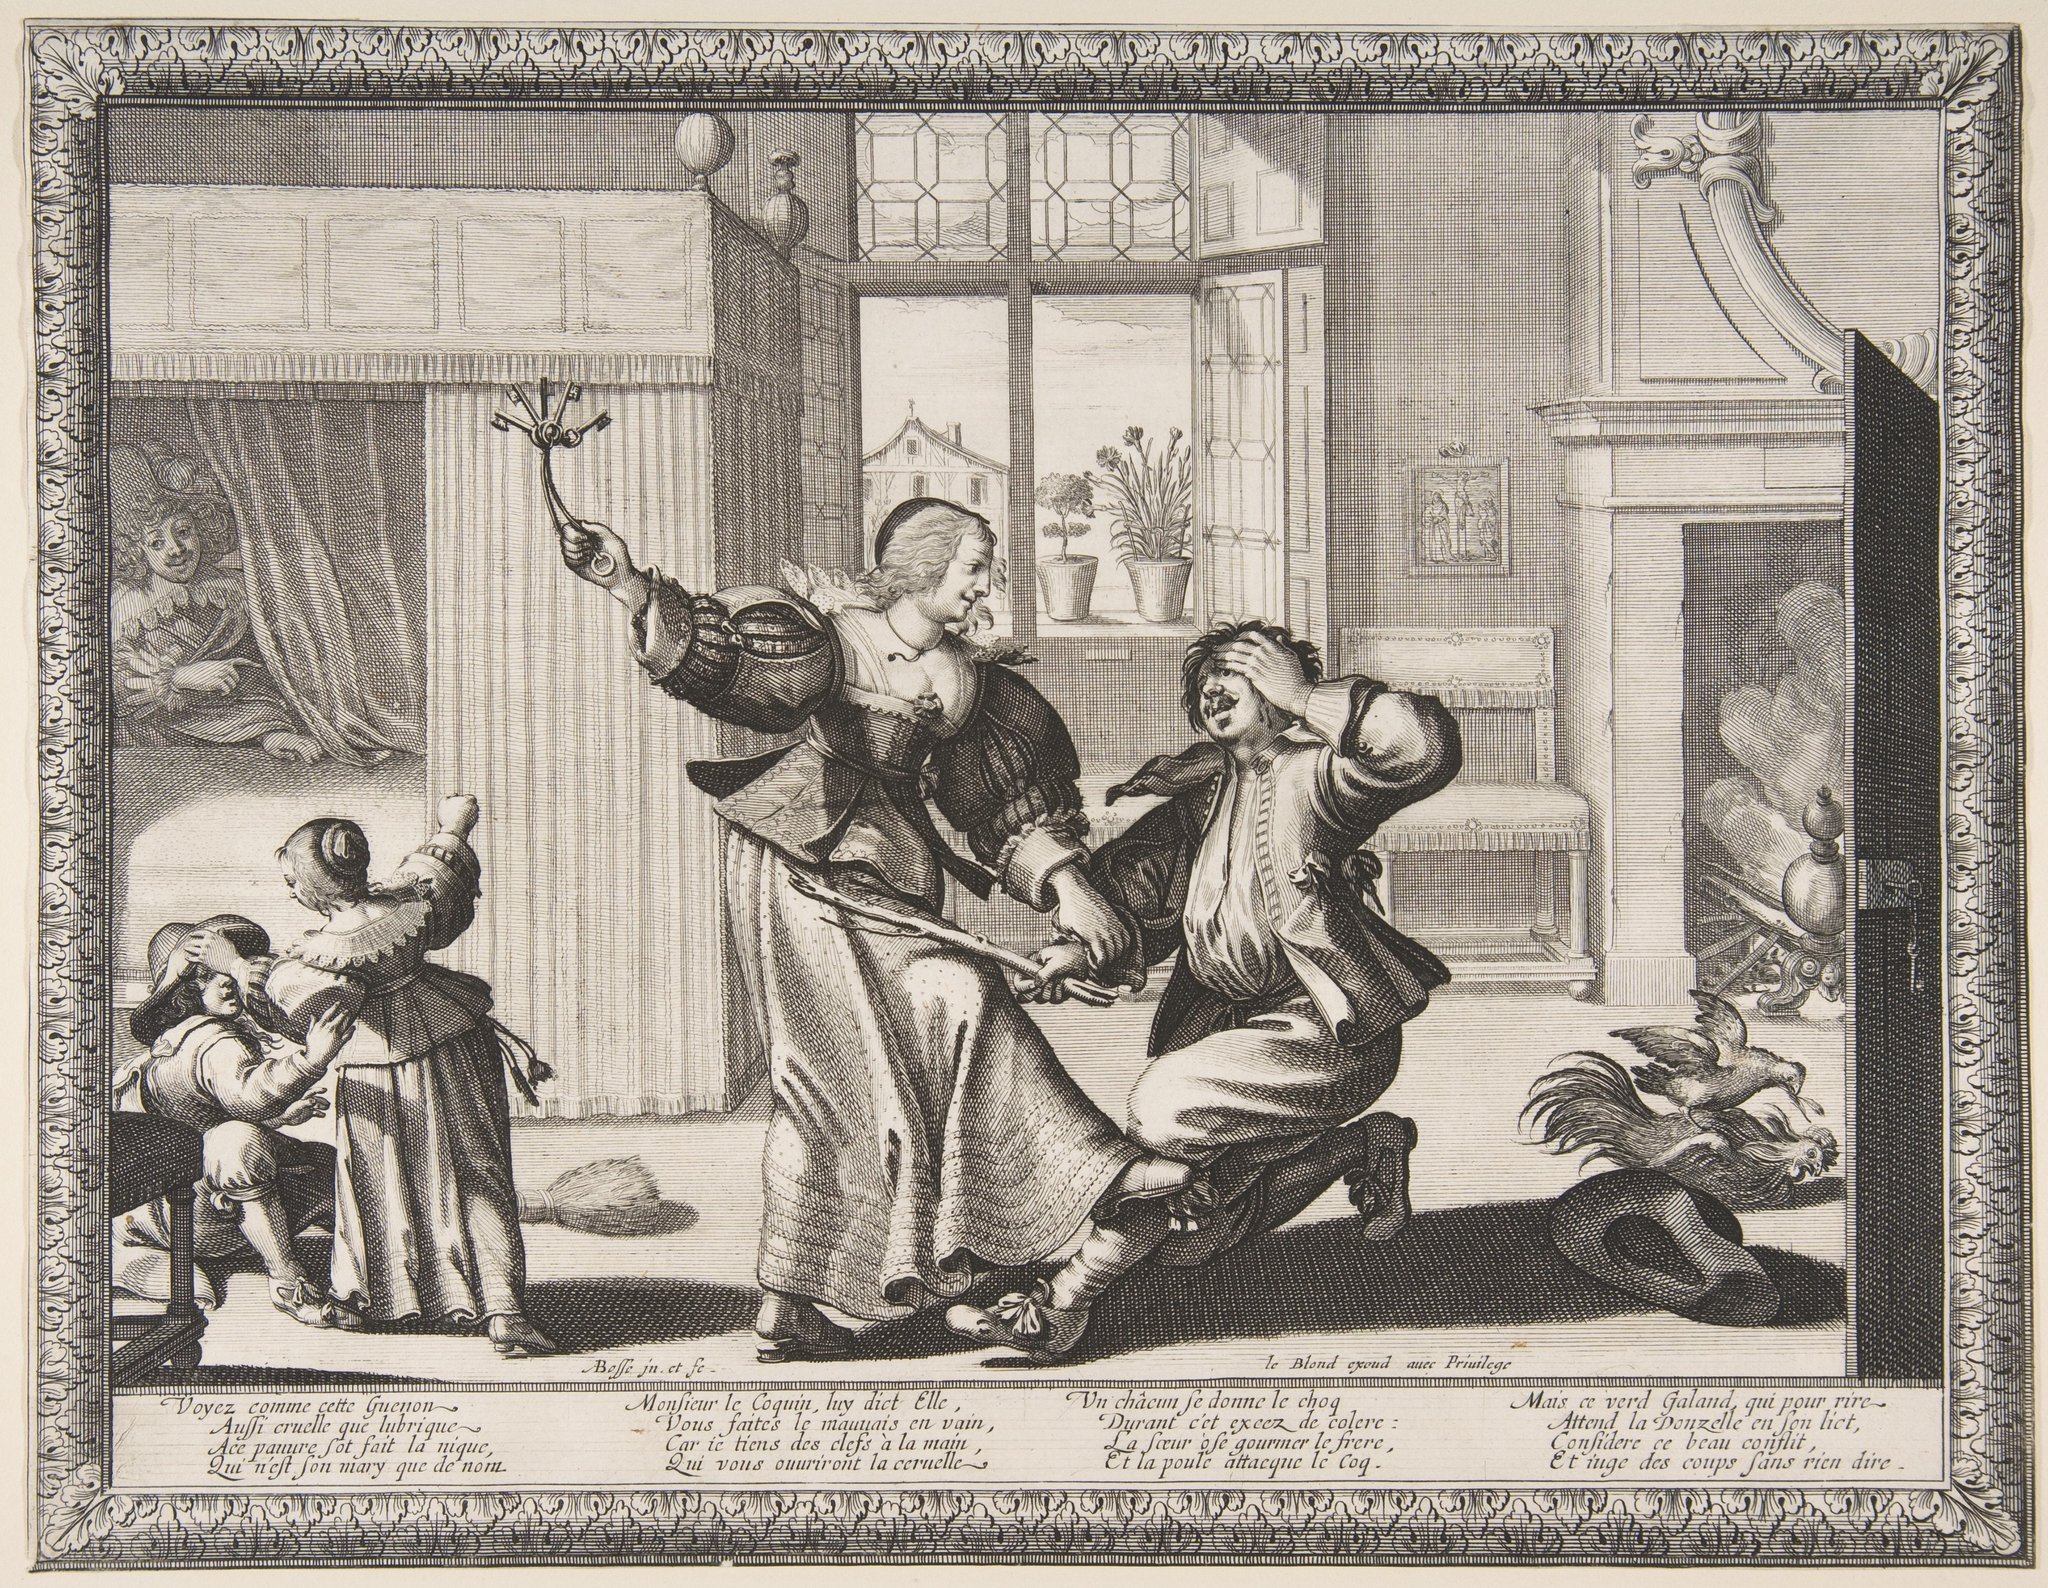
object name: print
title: The Husband-Beater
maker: abraham bosse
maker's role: artist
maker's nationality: french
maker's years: 1602-1676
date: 1633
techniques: engraving, etching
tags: bedrooms,couples,men,women,roosters